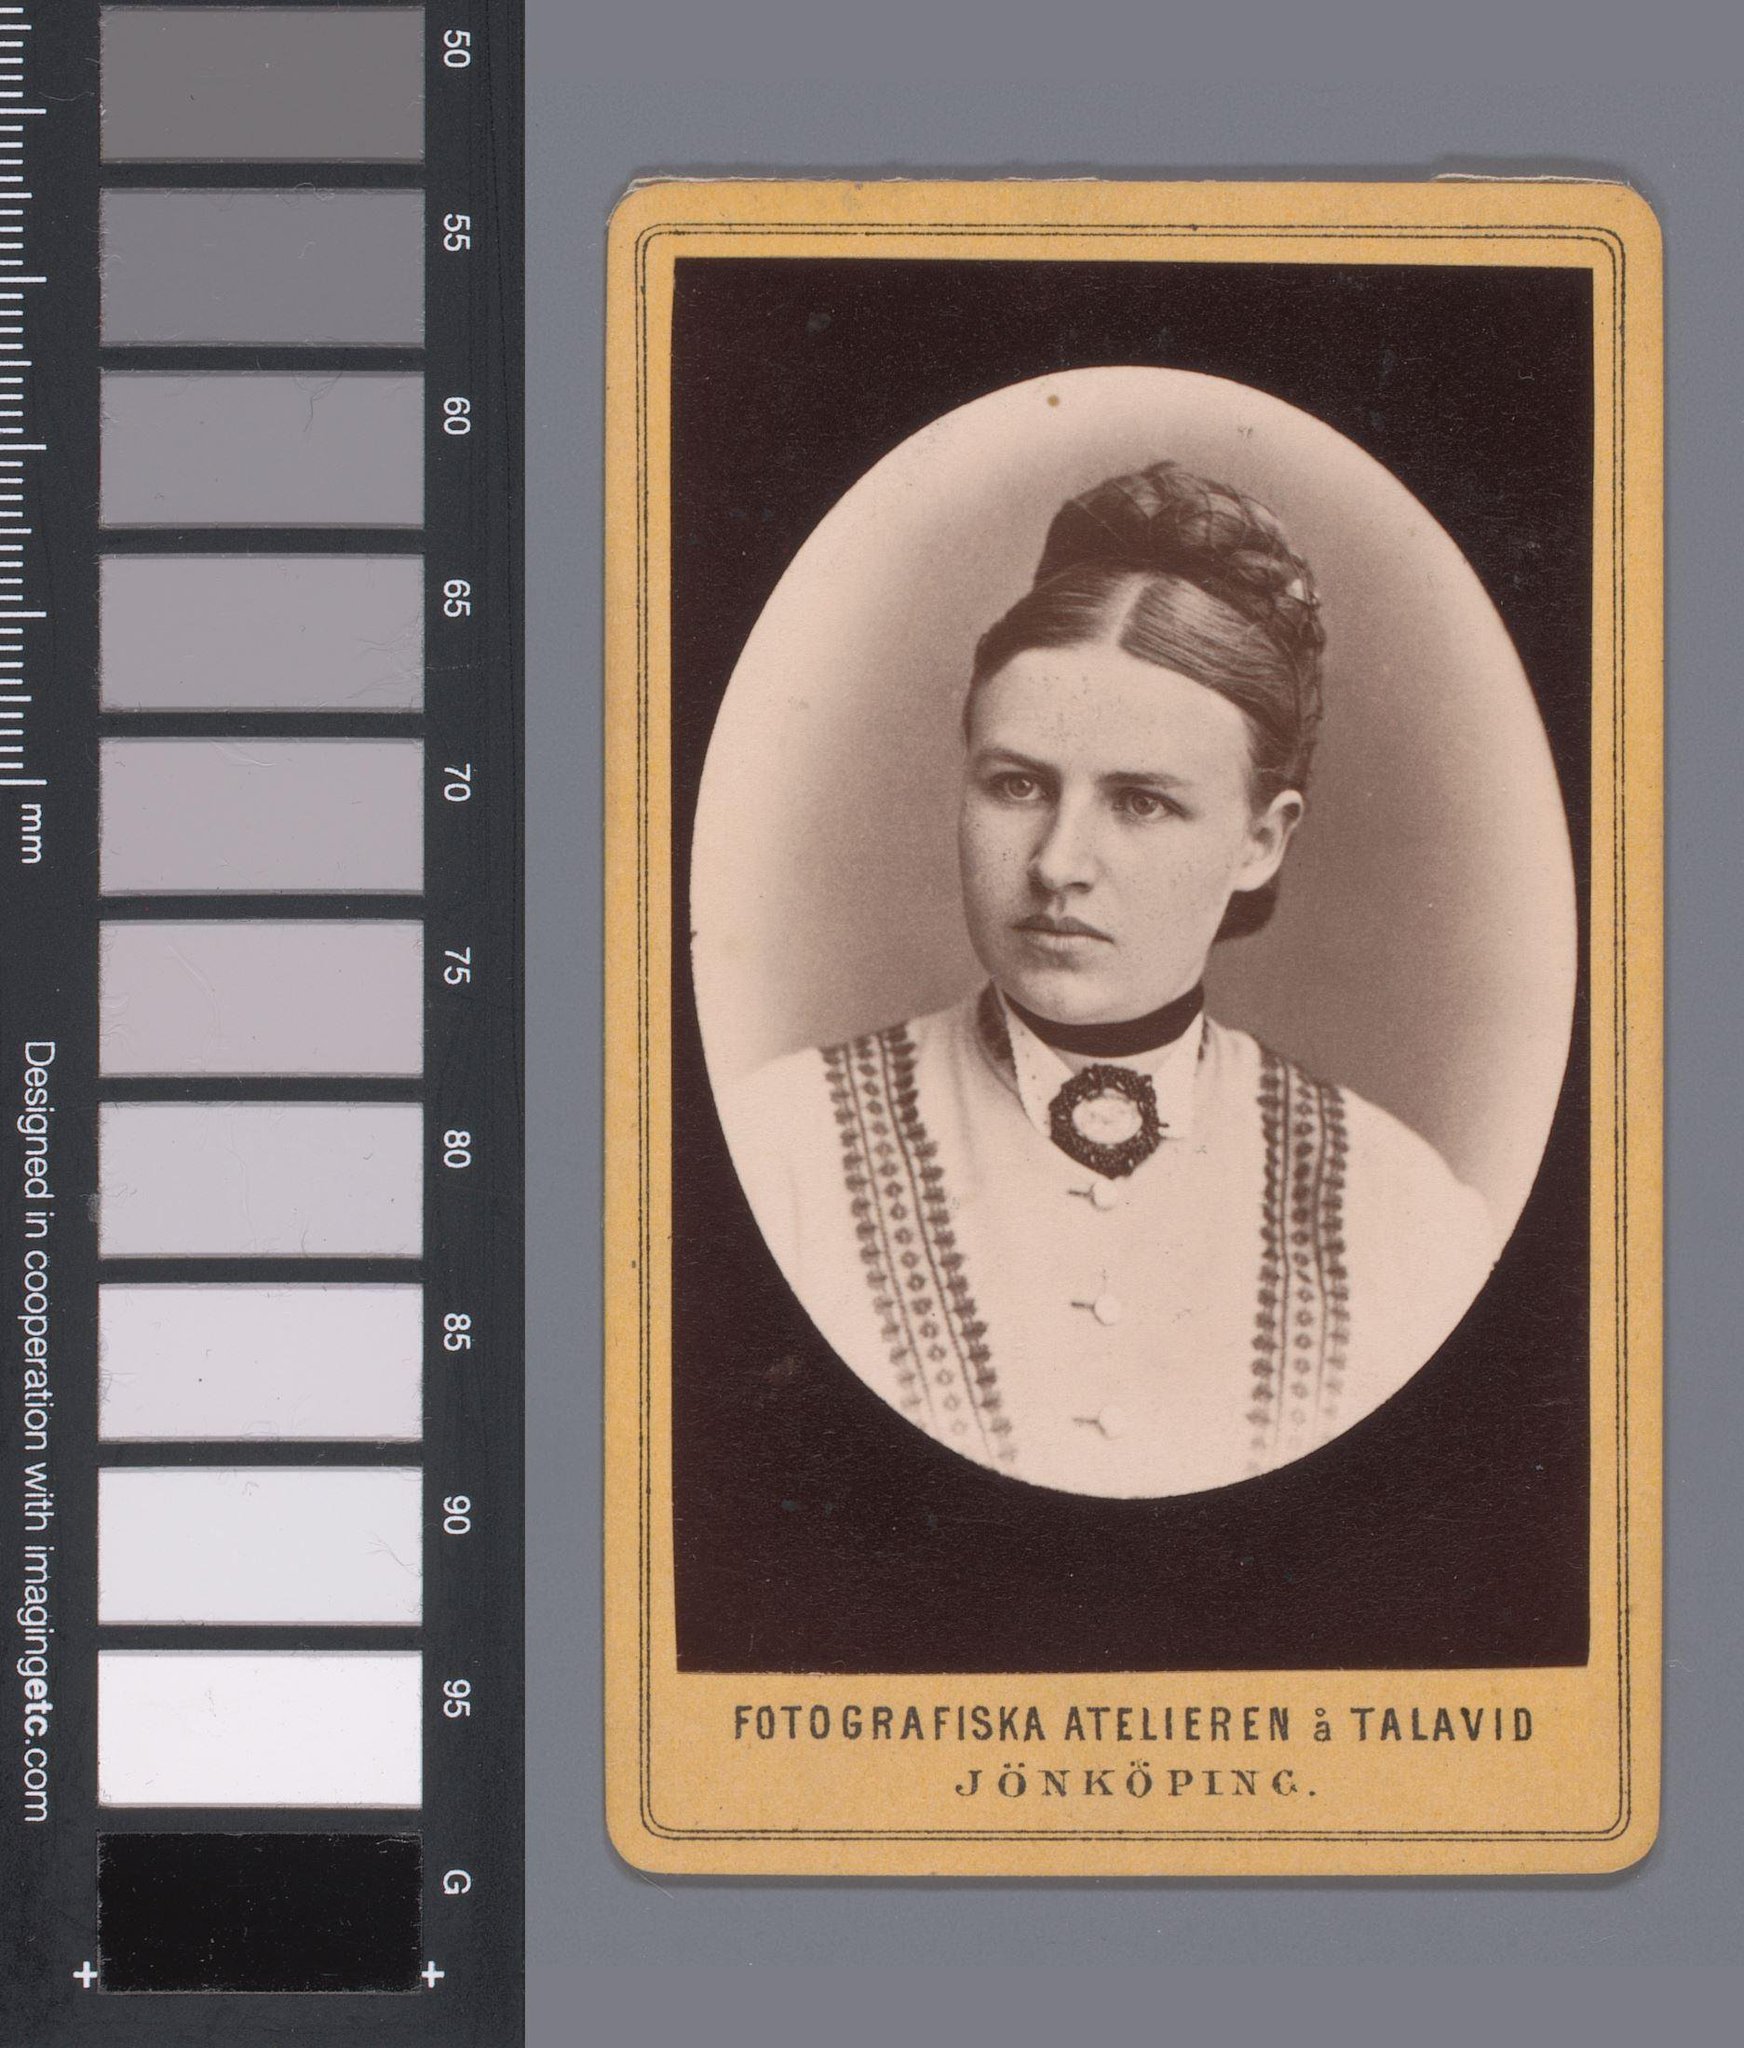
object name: carte de visite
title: Portret van een onbekende vrouw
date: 1874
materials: cardboard, paper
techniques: albumen print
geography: jönköping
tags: adolescent, young woman, maiden, historical persons - bb - woman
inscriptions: date: ‘1874 24/12’, name: ‘FOTOGRAFISKA ATELIEREN å TALAVID/ JÖNKÖPING.’